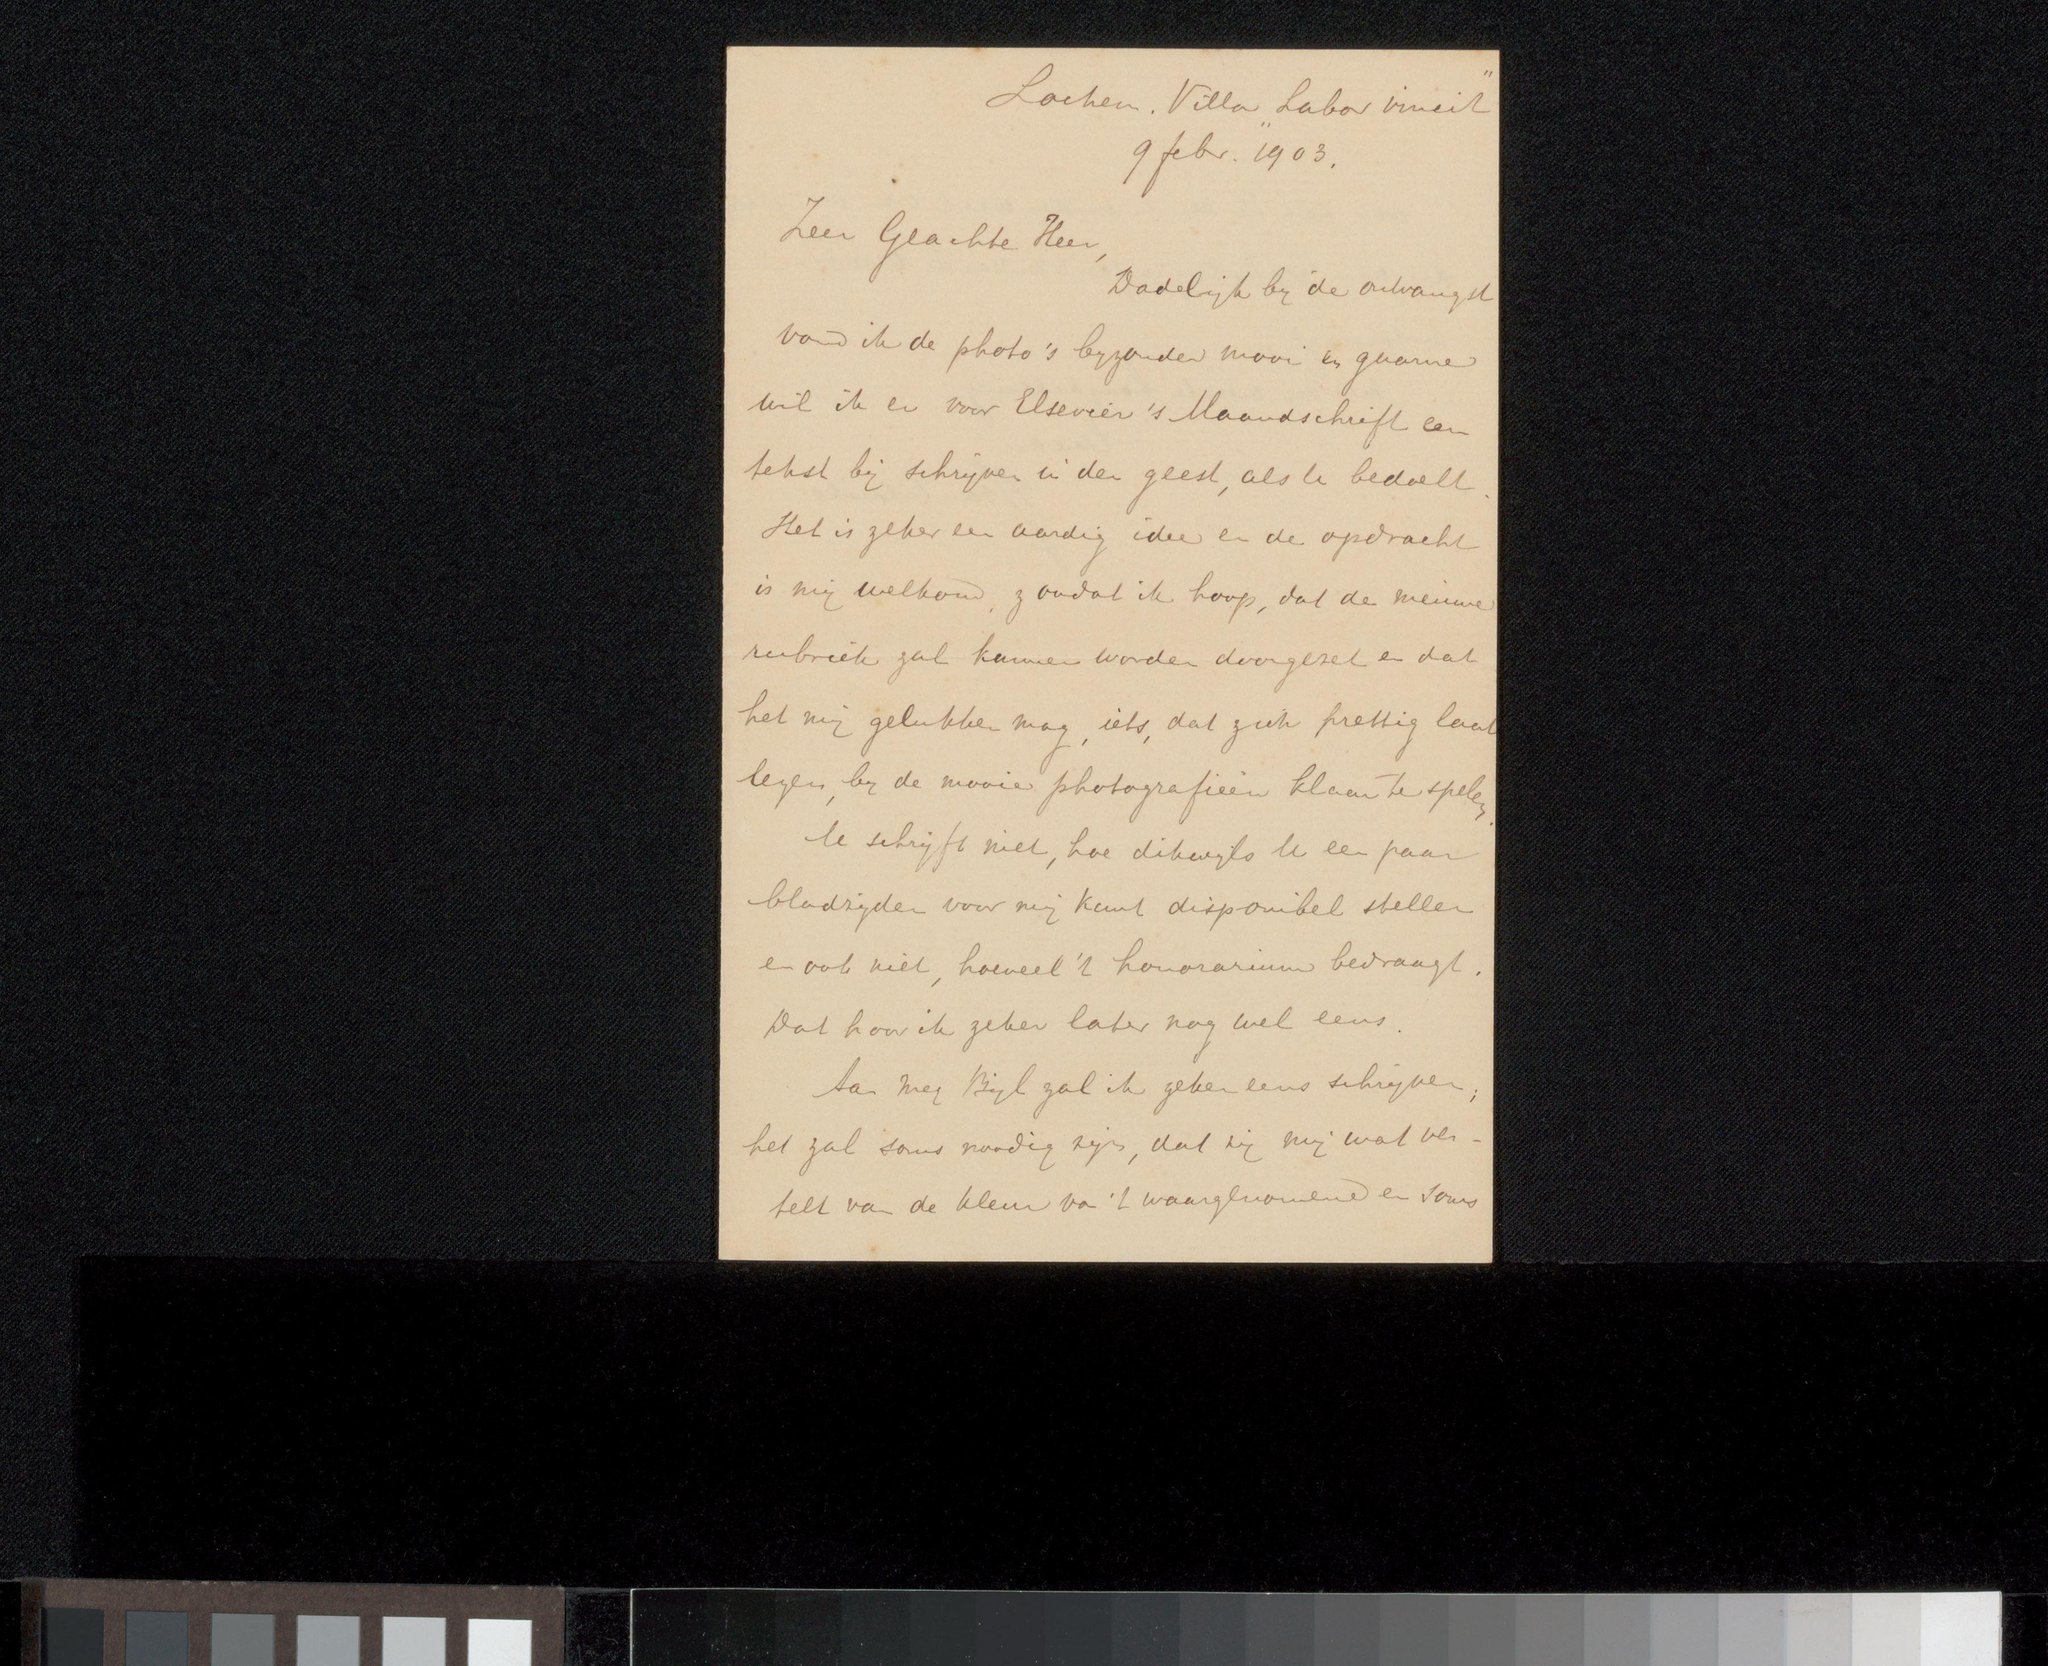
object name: letter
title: Brief aan Philip Zilcken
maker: frederike j. uildriks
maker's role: schrijver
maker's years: 1854-1919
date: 1903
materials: ink, paper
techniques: pen, writing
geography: lochem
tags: the hague, painter, draughtsman, philip zilcken, photography, cinematography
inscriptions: watermark, collector's mark: ‘RPK’